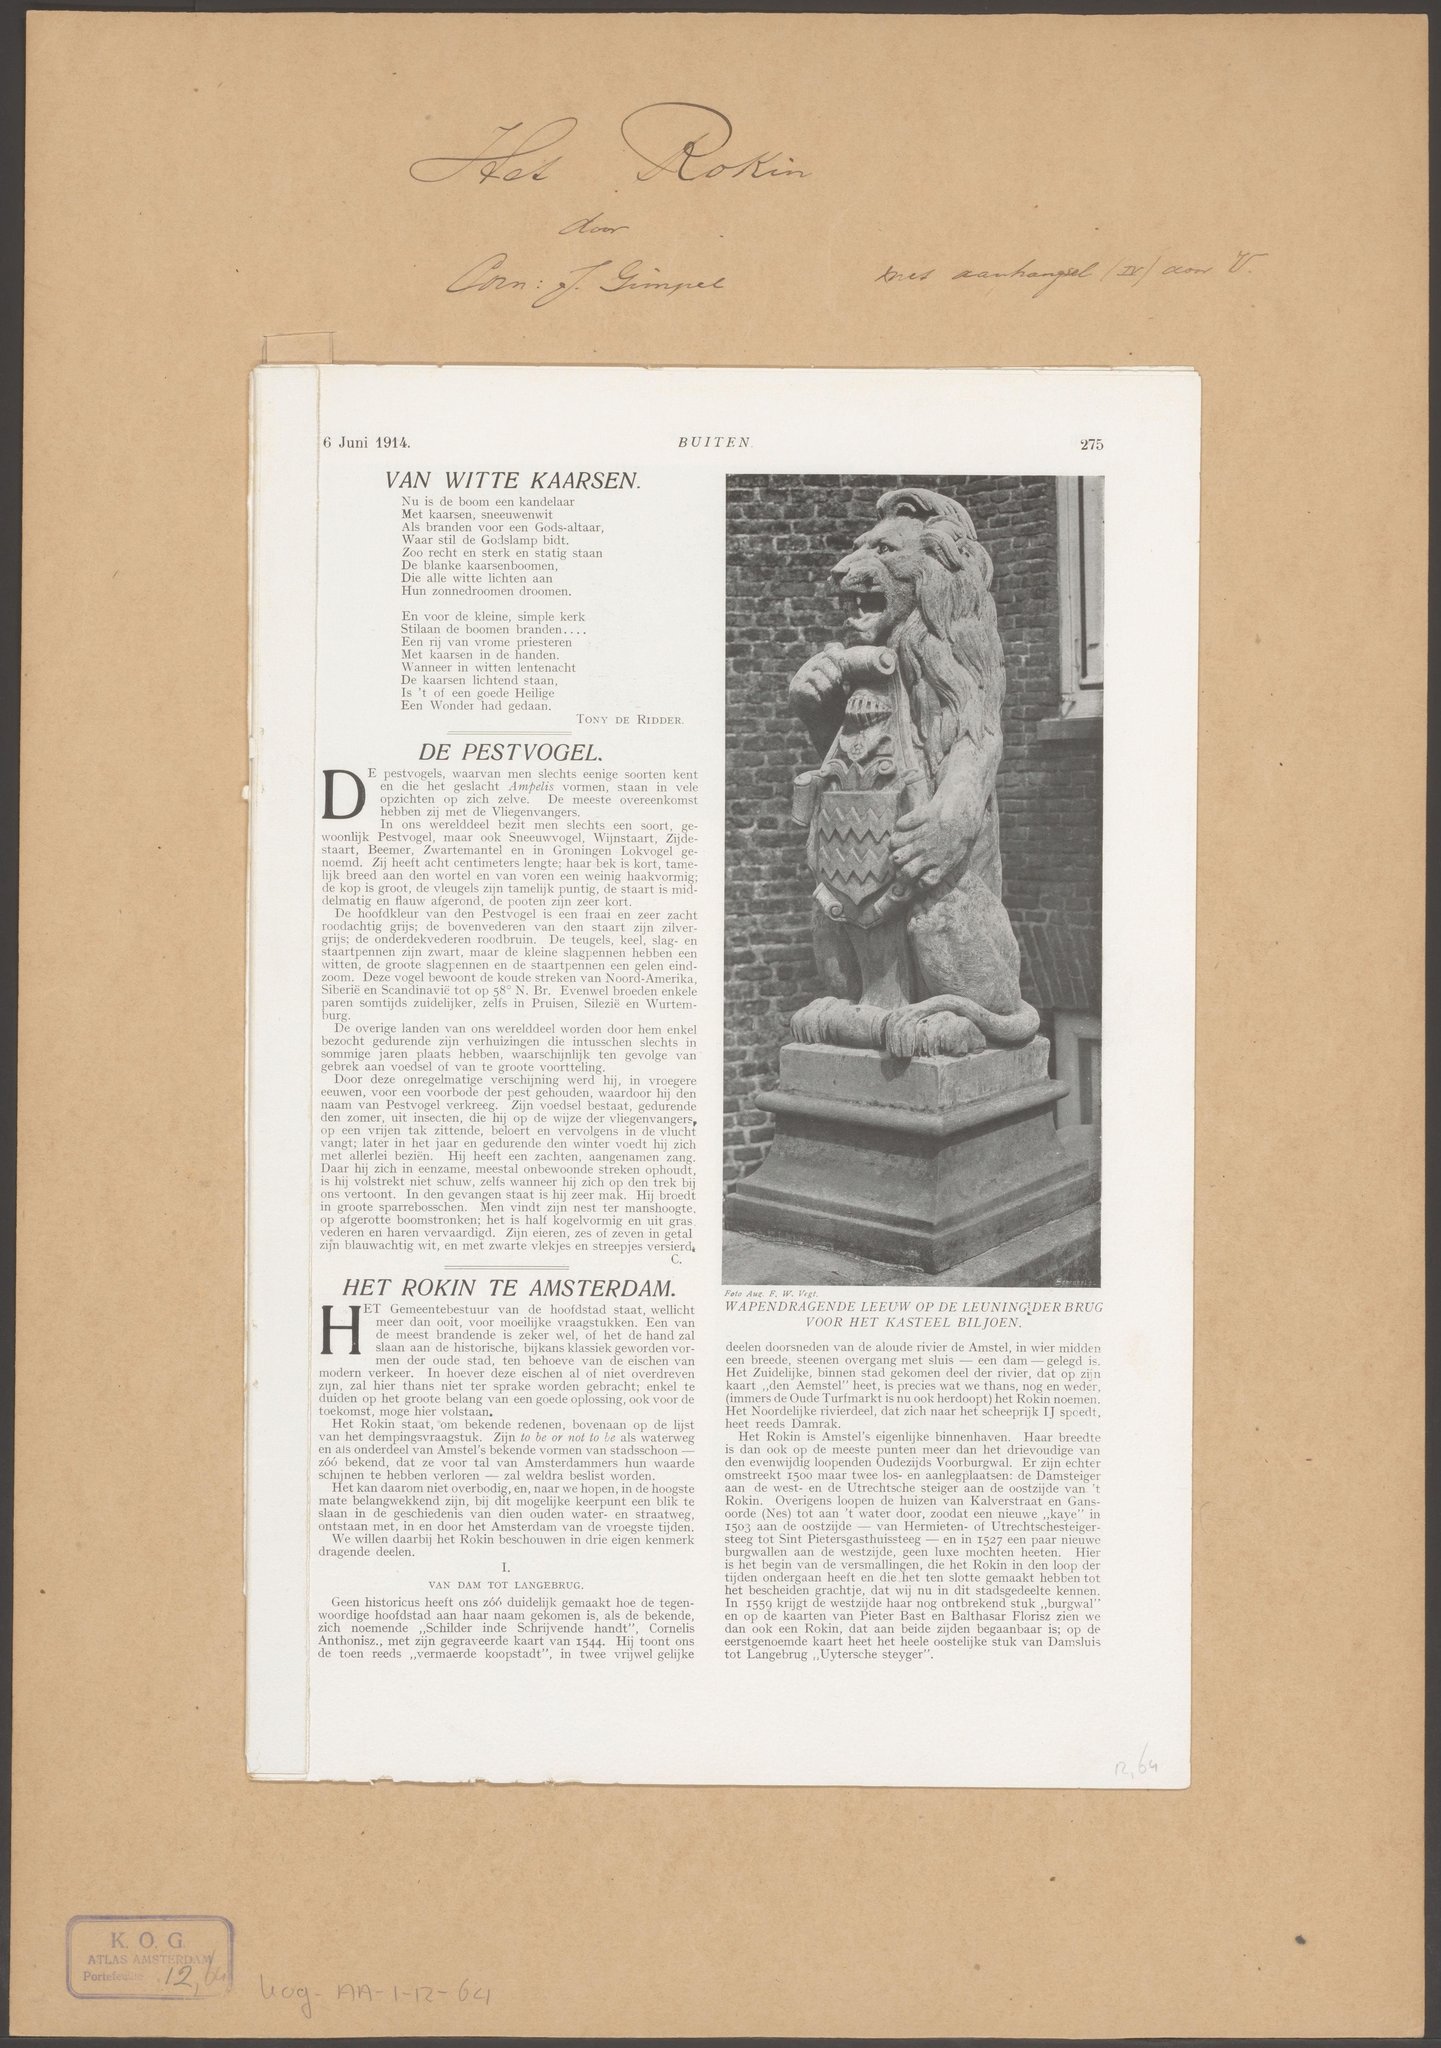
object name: photomechanical print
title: Tekstbladen over het Rokin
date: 1914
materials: paper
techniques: letterpress printing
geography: amsterdam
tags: city-view in general; 'veduta', canal, street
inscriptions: collector's mark: ‘12,64’ Lugt 1641b, inscription: ‘Het Rokin / door / Corn: J. Gimpel / met aanhangsel/IV/door [...].’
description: Onderwerpsrubriek binnen de Atlas Amsterdam: Rokin, Rotterdammersloot, Rozengang, Rozengracht, Rozenstraat, Rusland, Rustenburgerstraat, Ruysdaelkade, Ruysdaelstraat, Ruyterkade (de), Ruyterweg (Admiraal de). Zes bladzijden uit het tijdschrift Buiten over het Rokin.